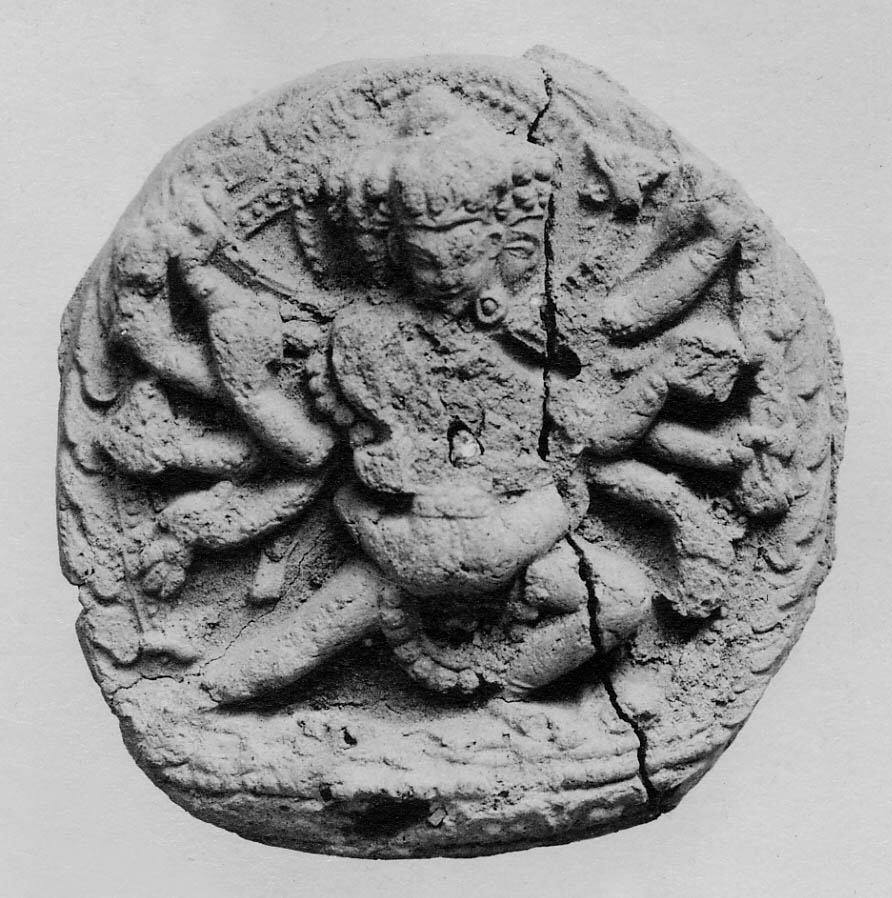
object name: plaque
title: Votive Plaque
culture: central asian or tibetan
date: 901-1600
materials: clay